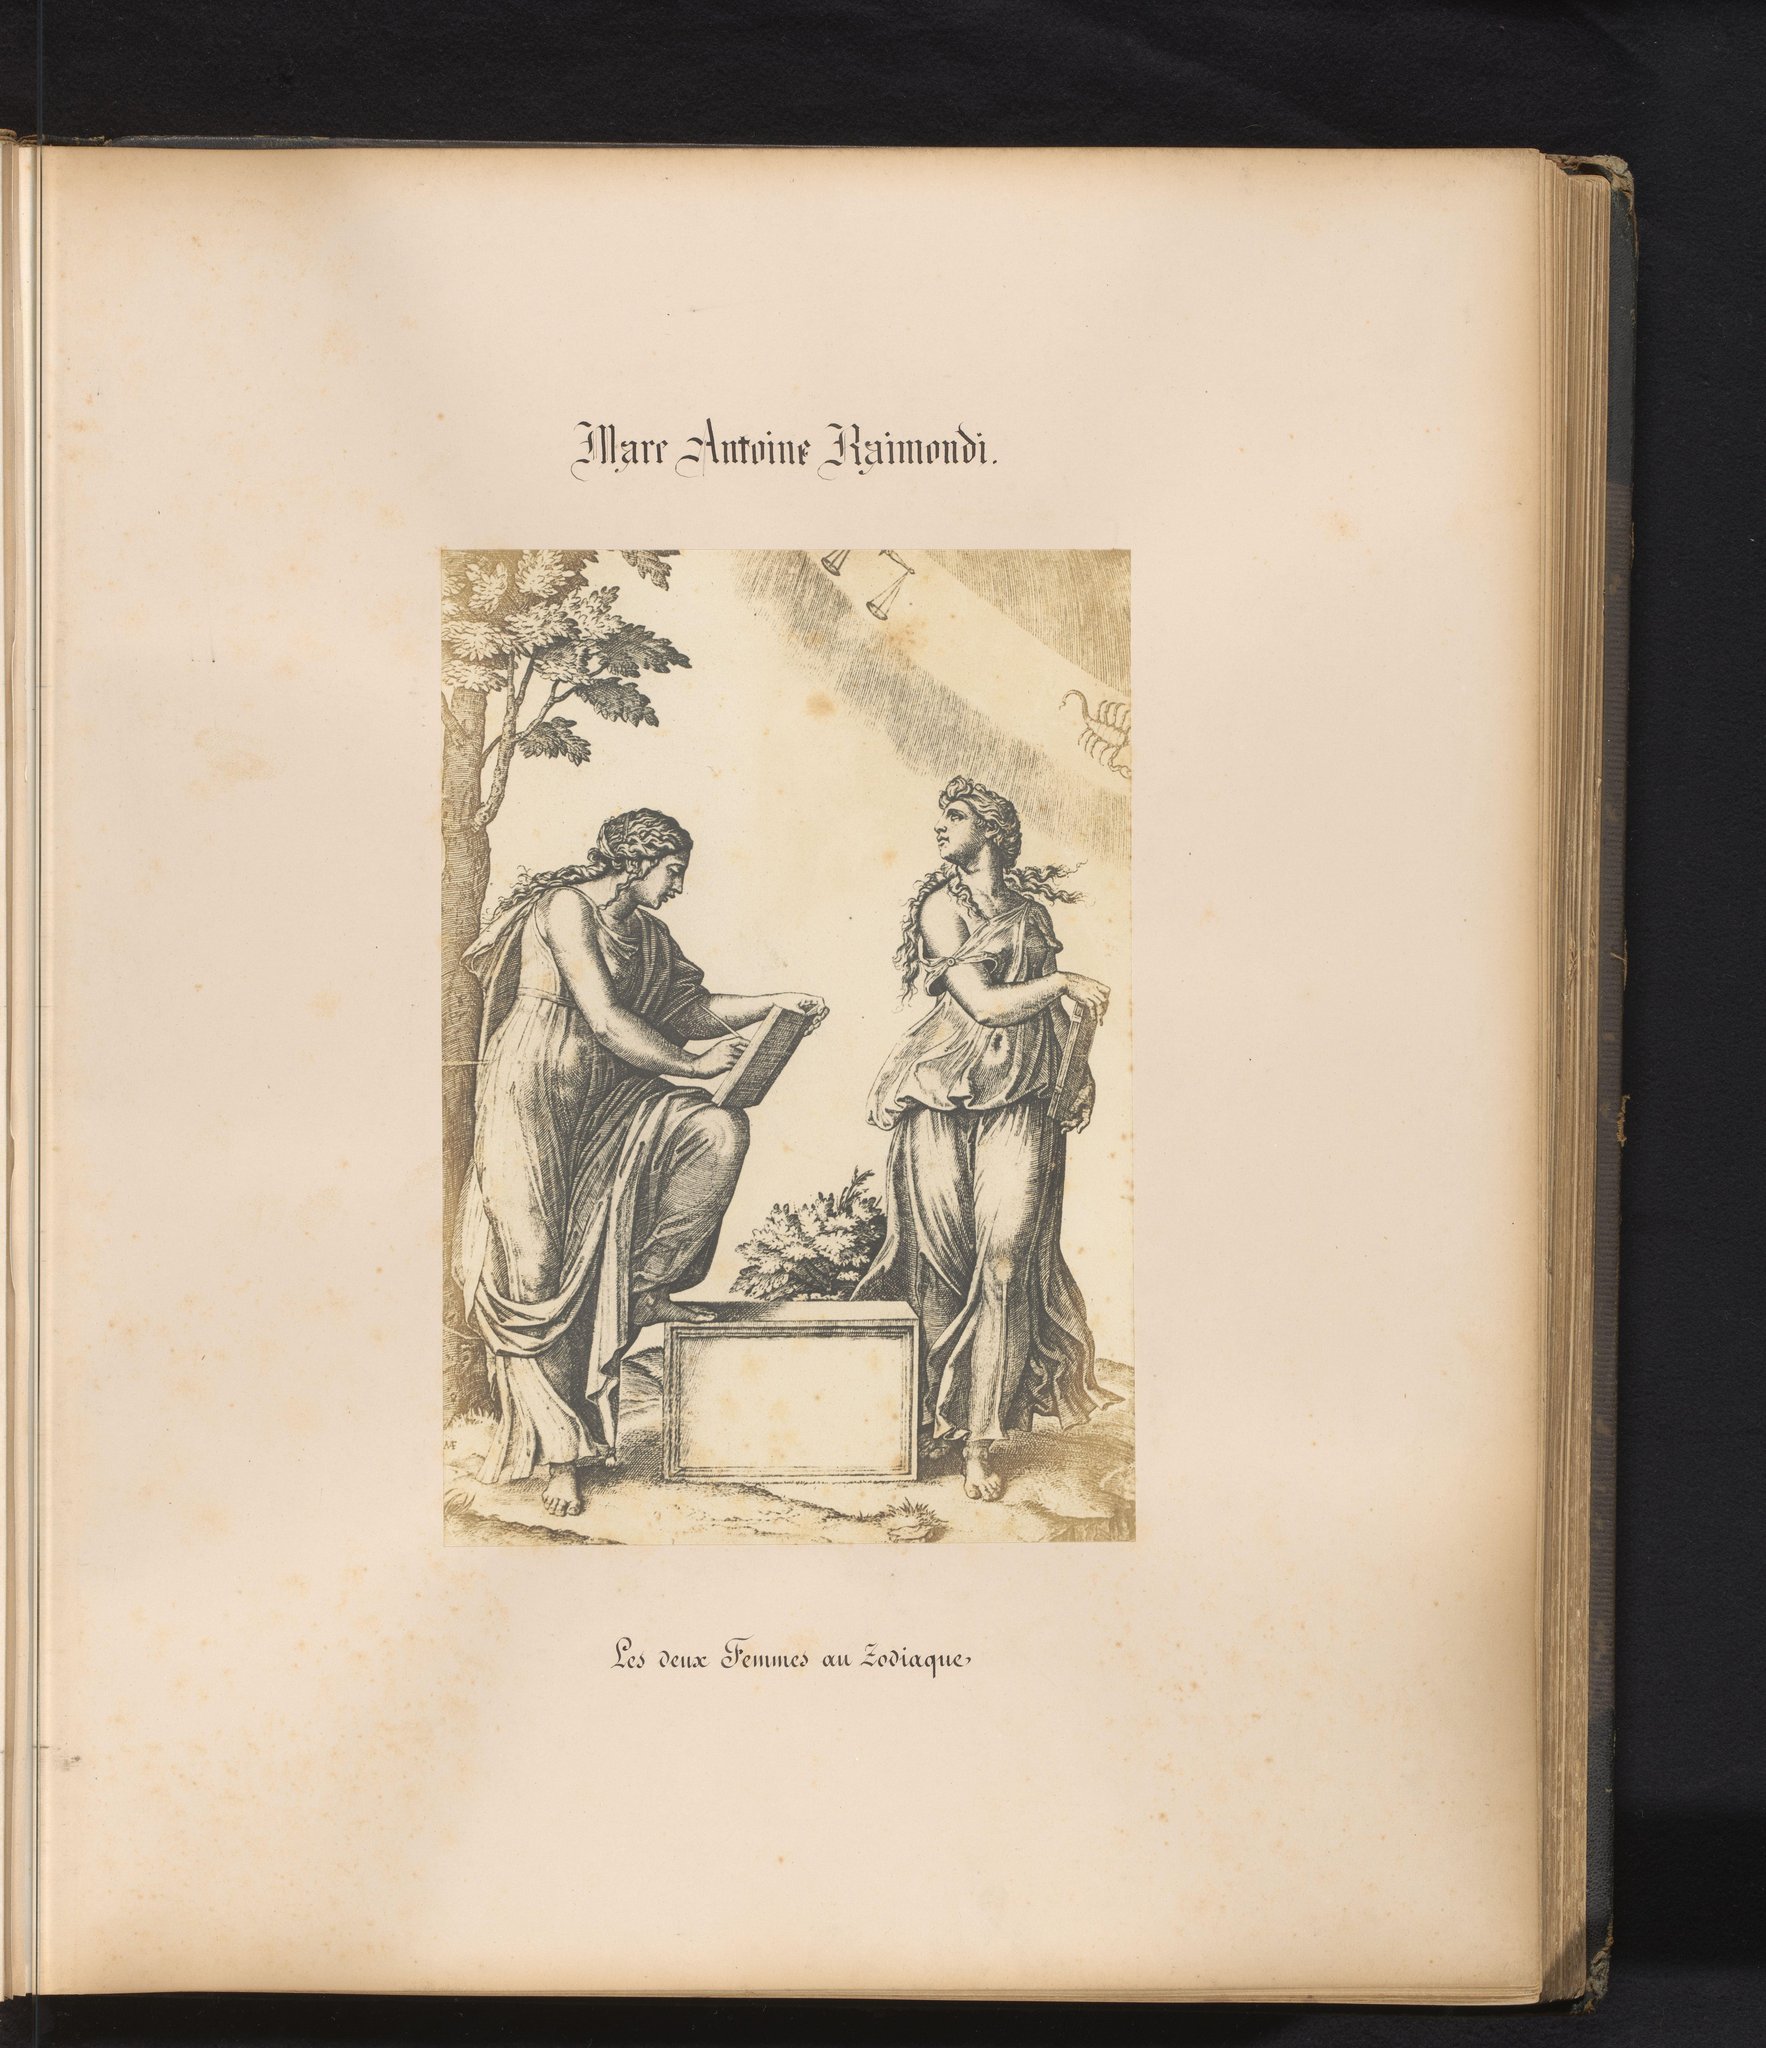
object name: reproduction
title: Marc Antoine Raimondi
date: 1848-1853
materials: photographic support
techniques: salted paper print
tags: adolescent, young woman, maiden (+ two persons), zodiac; the twelve zodiacal signs together